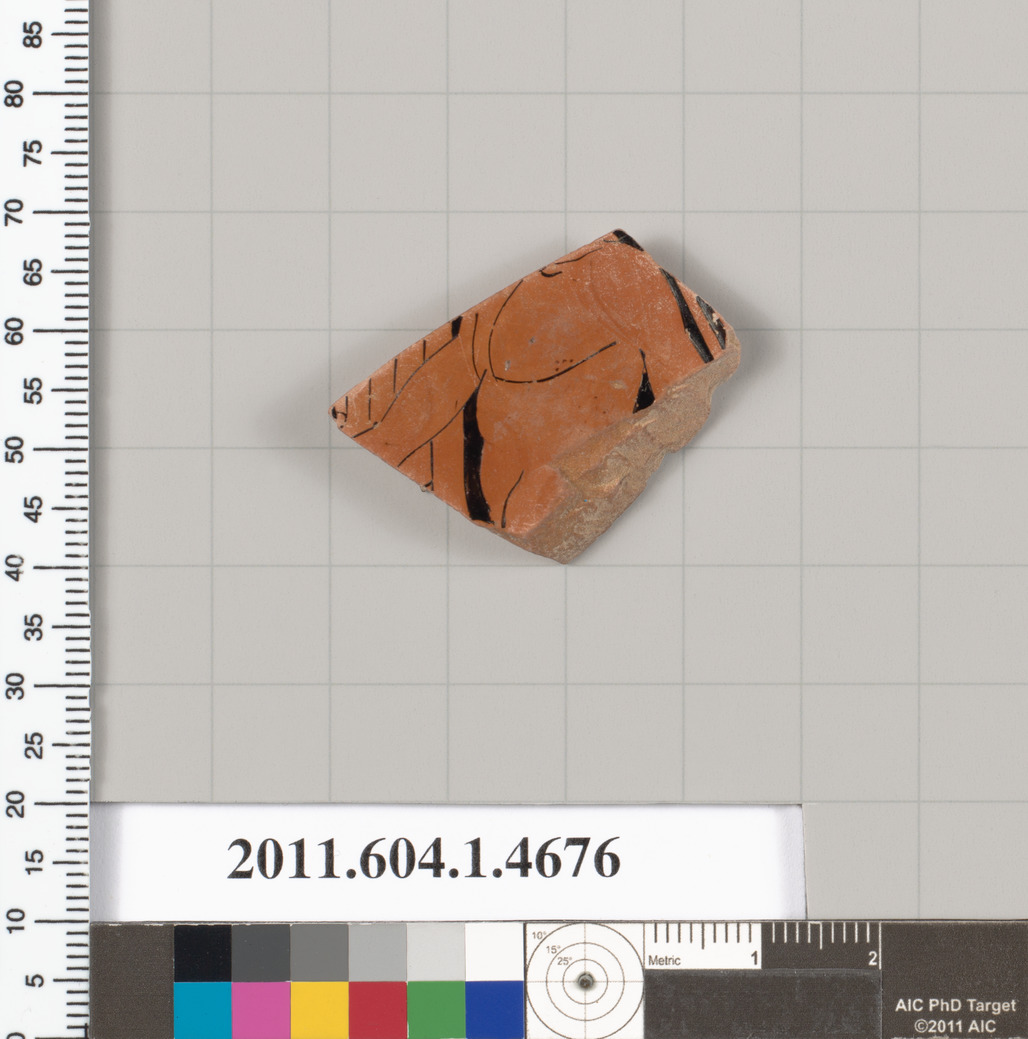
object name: kylix fragment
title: Terracotta fragment of a kylix (drinking cup)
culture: greek, attic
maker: douris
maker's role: artist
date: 490-470 BCE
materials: terracotta